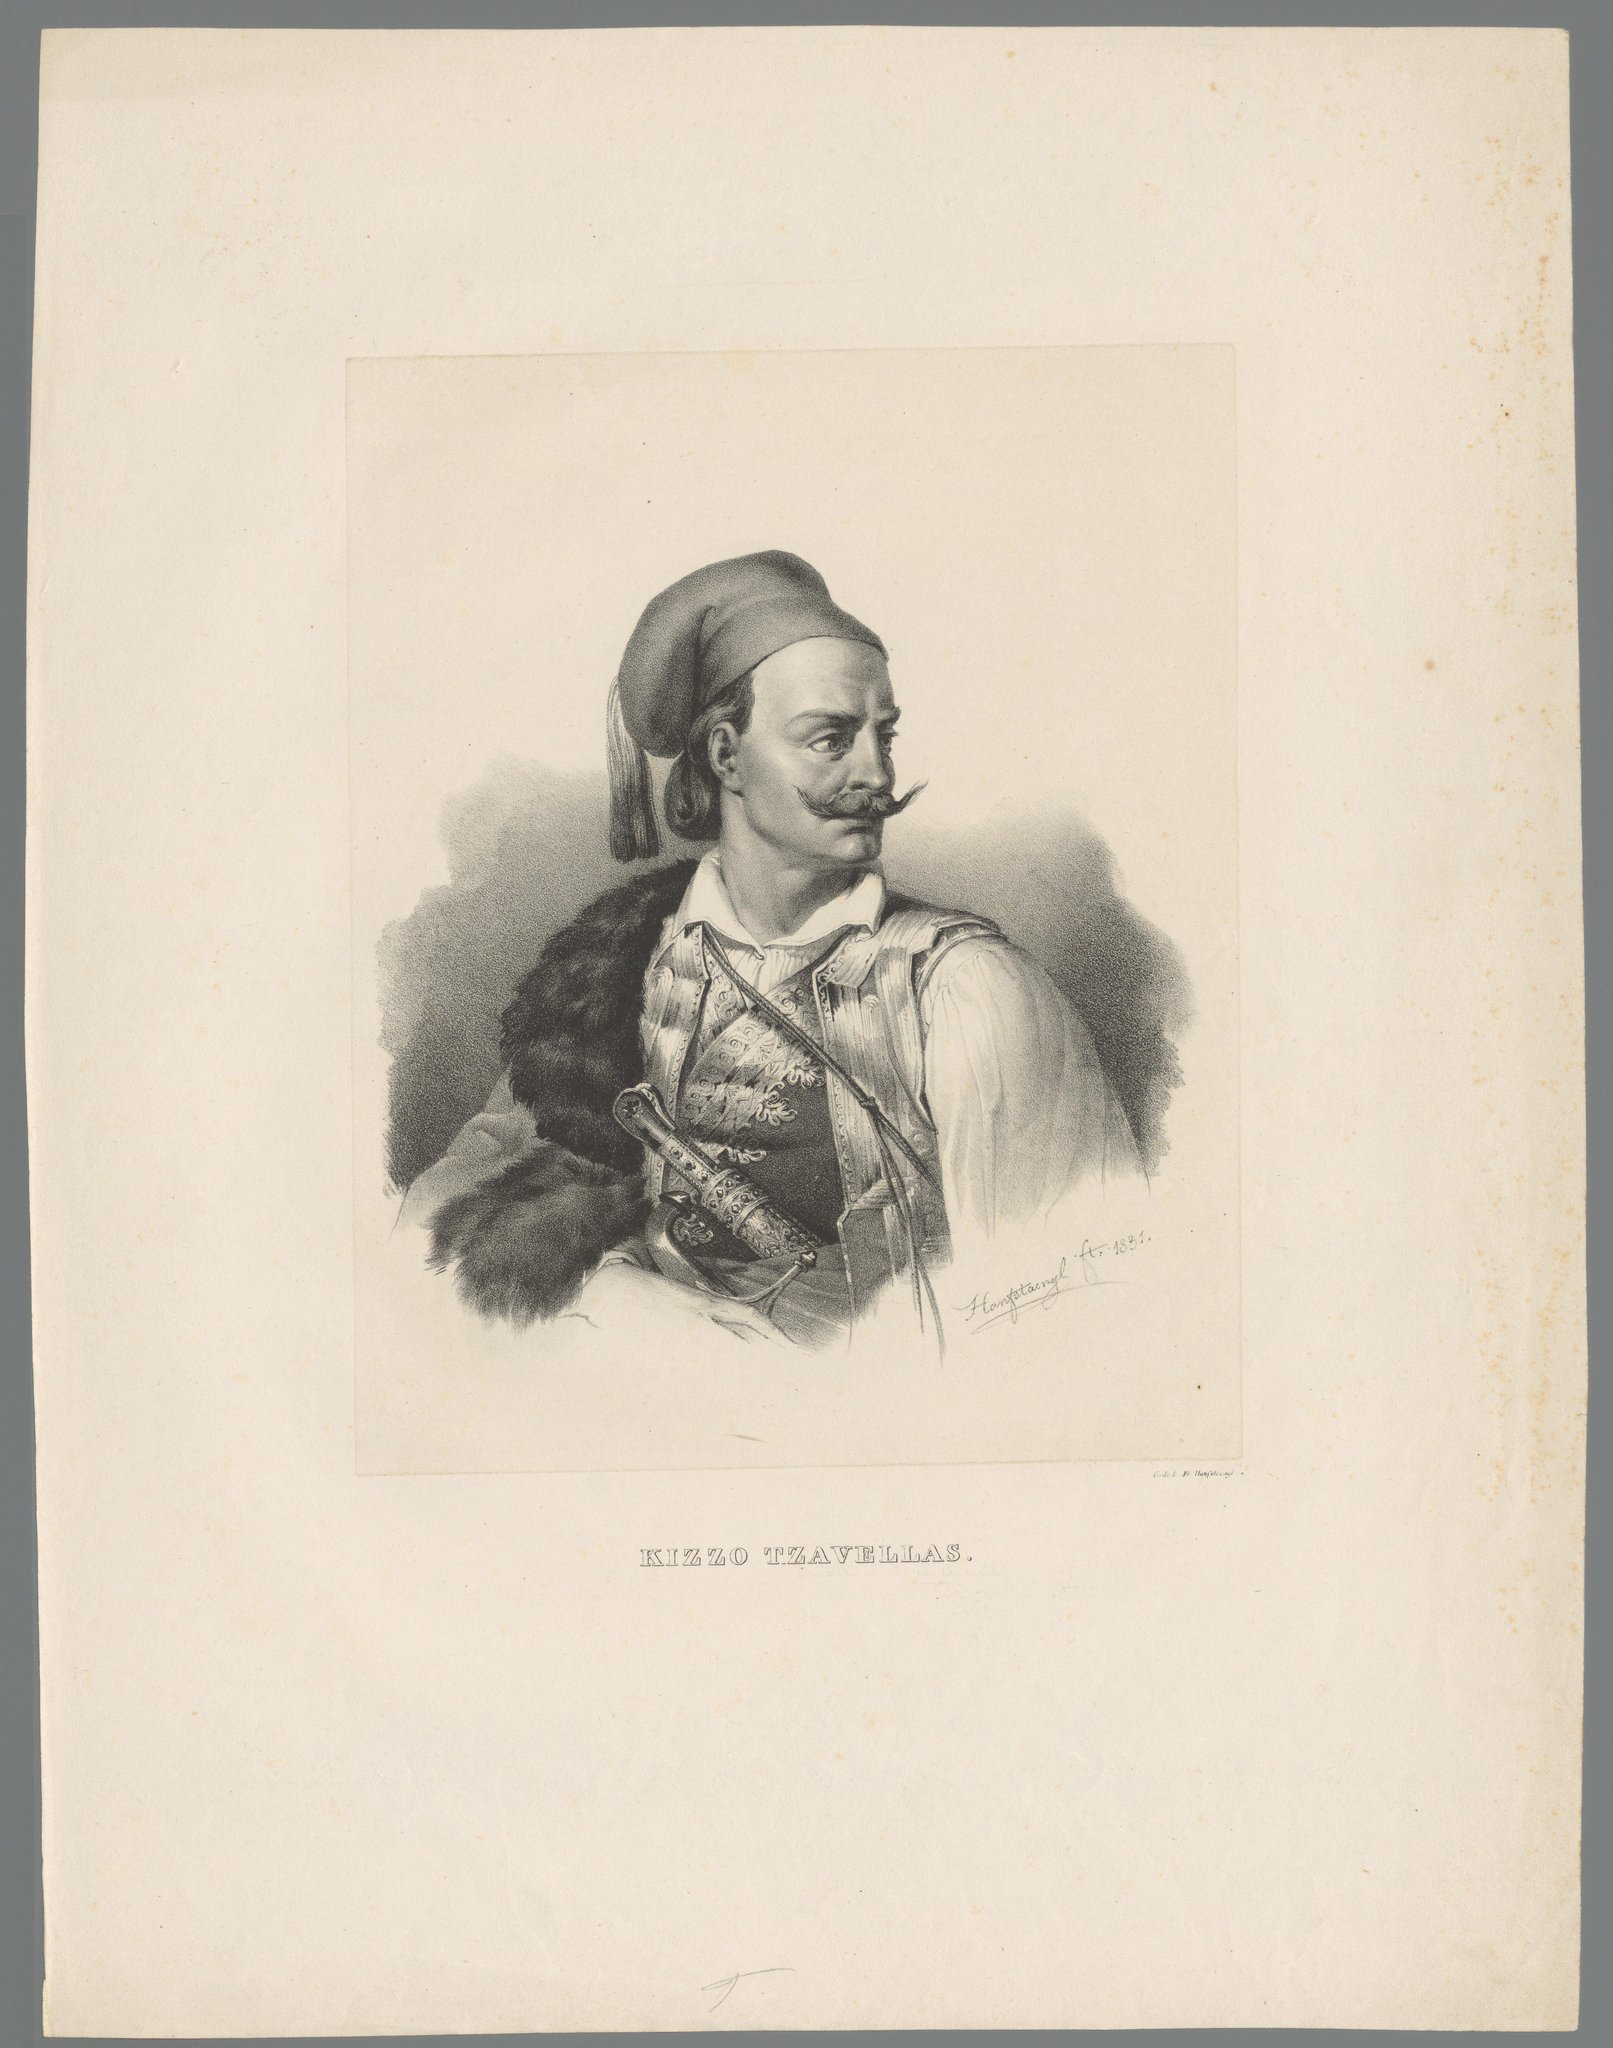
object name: print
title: Portret van Kitsos Tzavelas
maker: franz seraph hanfstaengl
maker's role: painter, print maker, printer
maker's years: 1804-1877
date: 1831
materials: paper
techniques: tone lithography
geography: munich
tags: politician, moustache, adult man, historical persons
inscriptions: collector's mark: Lugt 2228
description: De prent hoort mogelijk bij een serie prenten met portretten van betrokkenen bij de Griekse onafhankelijkheidsoorlog. Mogelijk de serie: Bildnisse ausgezeichneter Greichen und Philhellene nebst einigen Ansichten und Trachten.